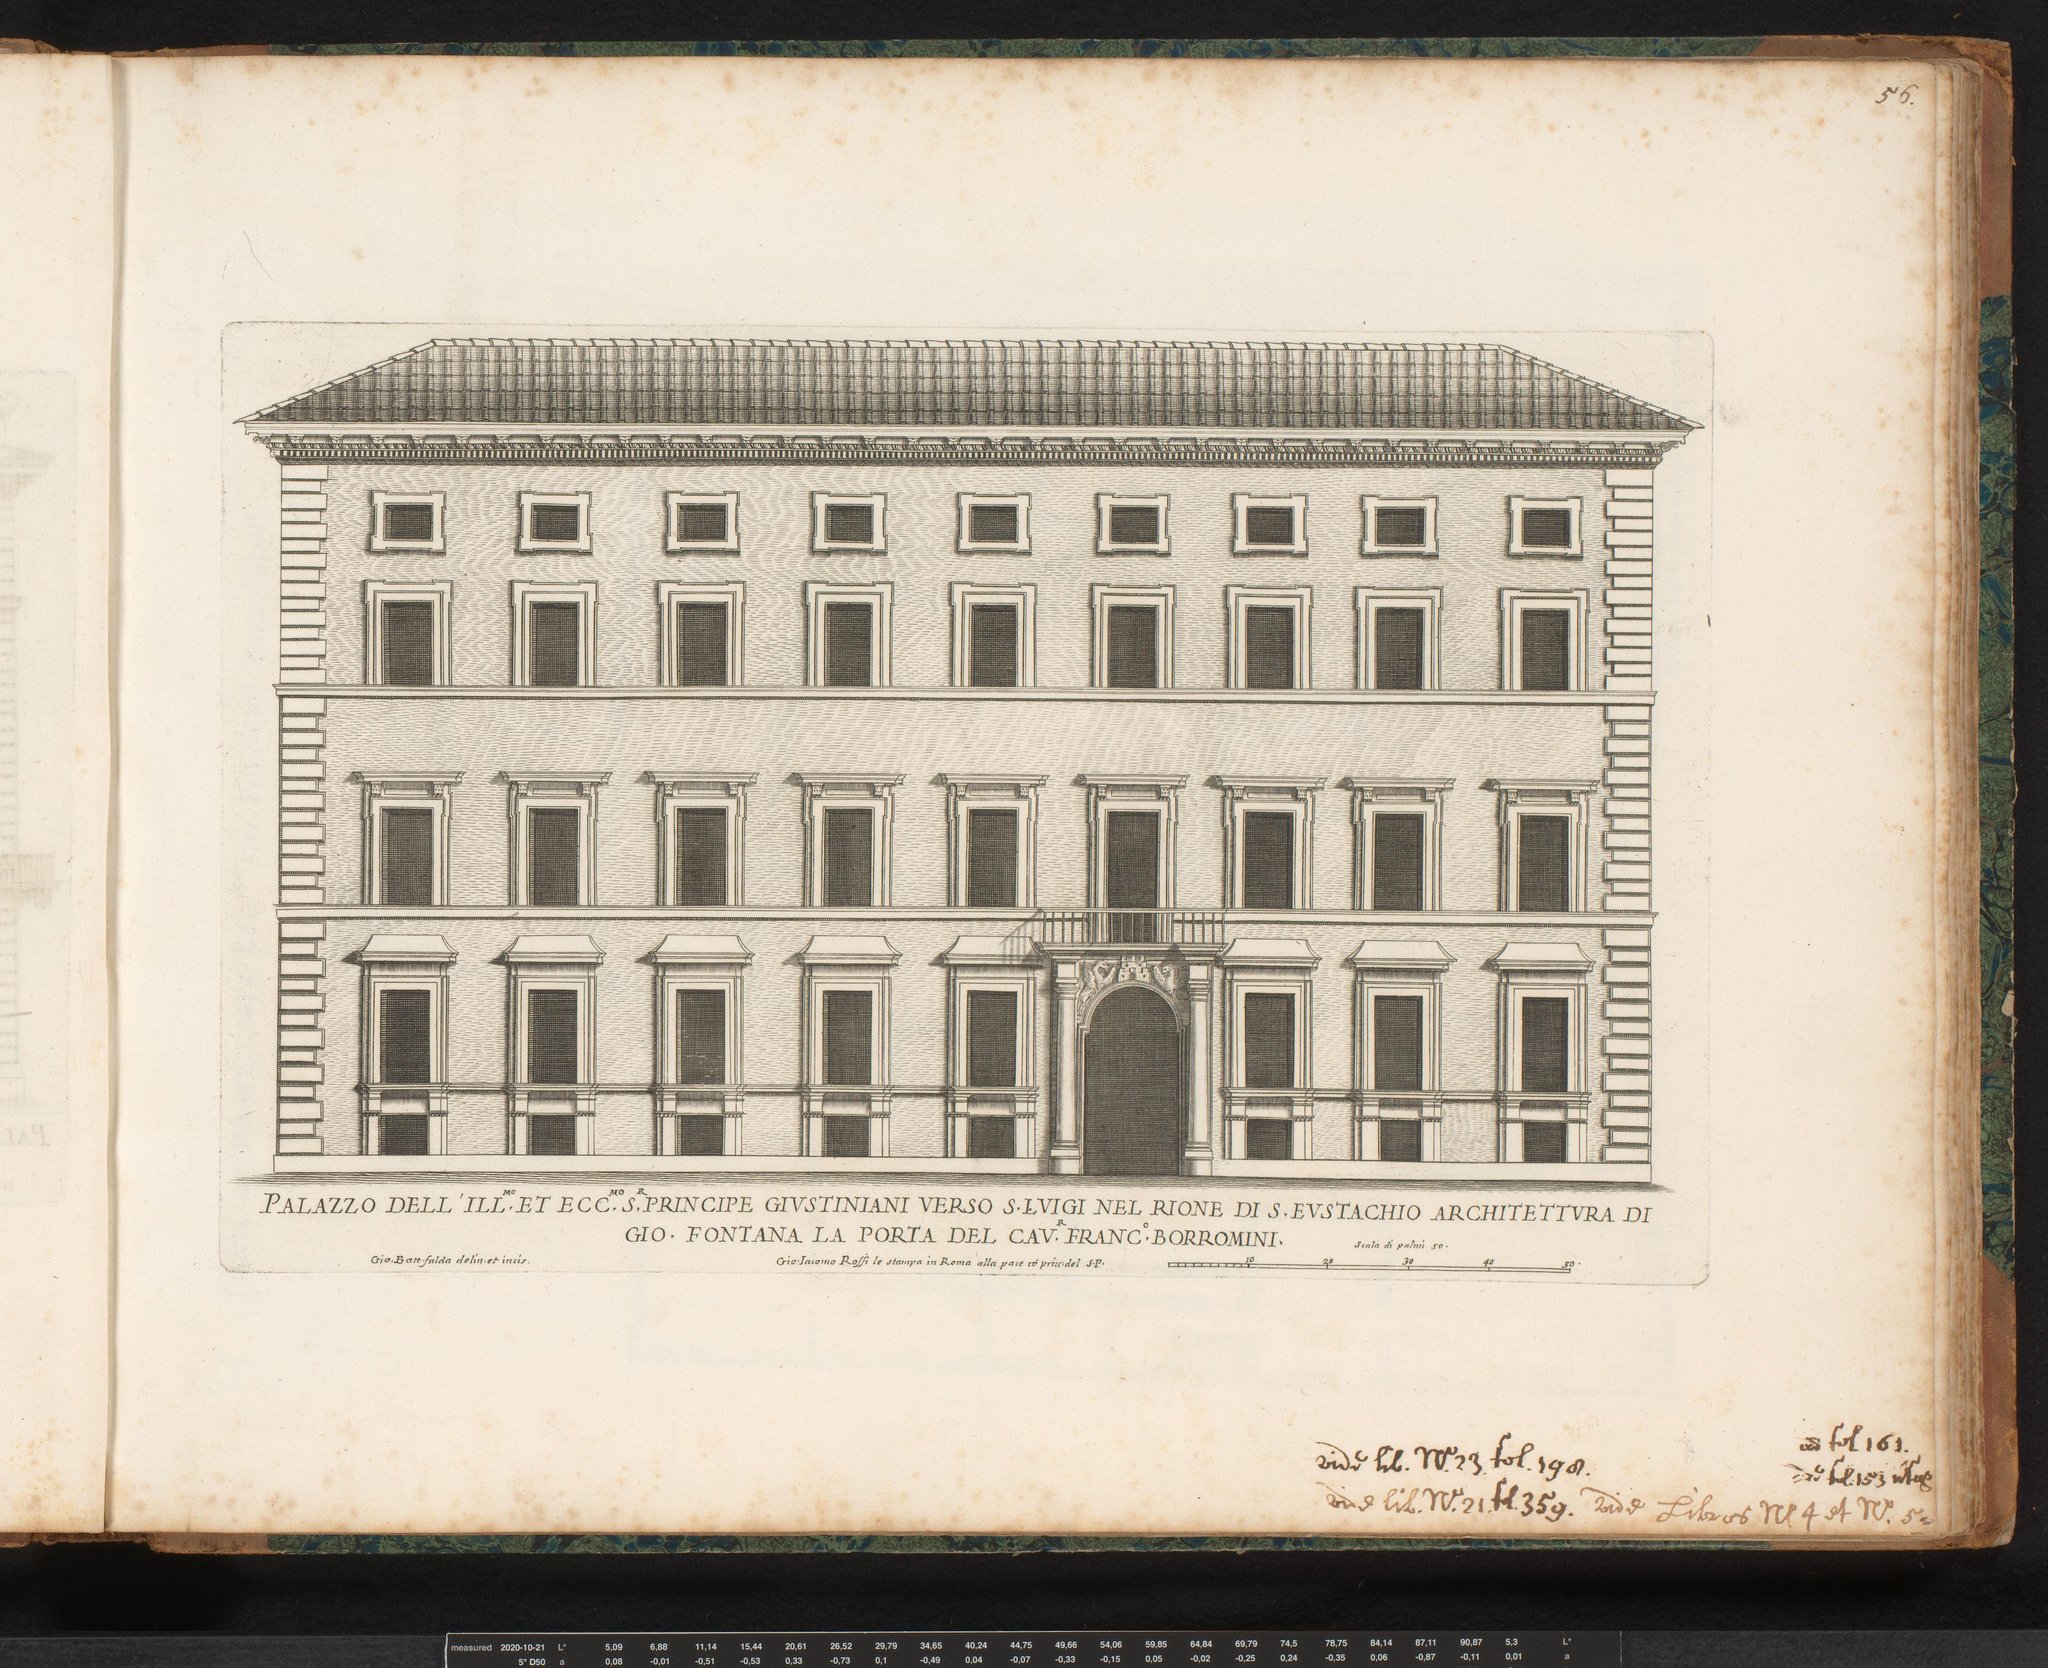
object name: album leaf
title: Façade van Palazzo Giustiniani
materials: paper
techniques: etching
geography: italy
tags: palace, façade (of house or building)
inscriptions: inscription: ‘Ende lib. No. 23. fol. 198./ Ende lib. No. 21. fol. 359...’, number: ‘56’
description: Deze prent maakt deel uit van de reeks getiteld: Palazzi di Roma. Deze reeks bestaat uit twee boeken. Boek één getiteld: Palazzi di Roma dei più celebri architetti..., bestaat uit 44 prenten die worden toegeschreven aan Giovanni Battista Falda (naam staat enkel op prent 27) en uitgegeven door Giovanni Giacomo de'Rossi. Deze 44 prenten zijn bekend in twee staten (met en zonder nummer). Boek twee getiteld: Nuovi disegni dell'architetture... libro secondo, bevat 66 prenten door Giovanni Battista Falda en Simone Felice. Deze 66 prenten zijn bekend in twee staten (met en zonder nummer).